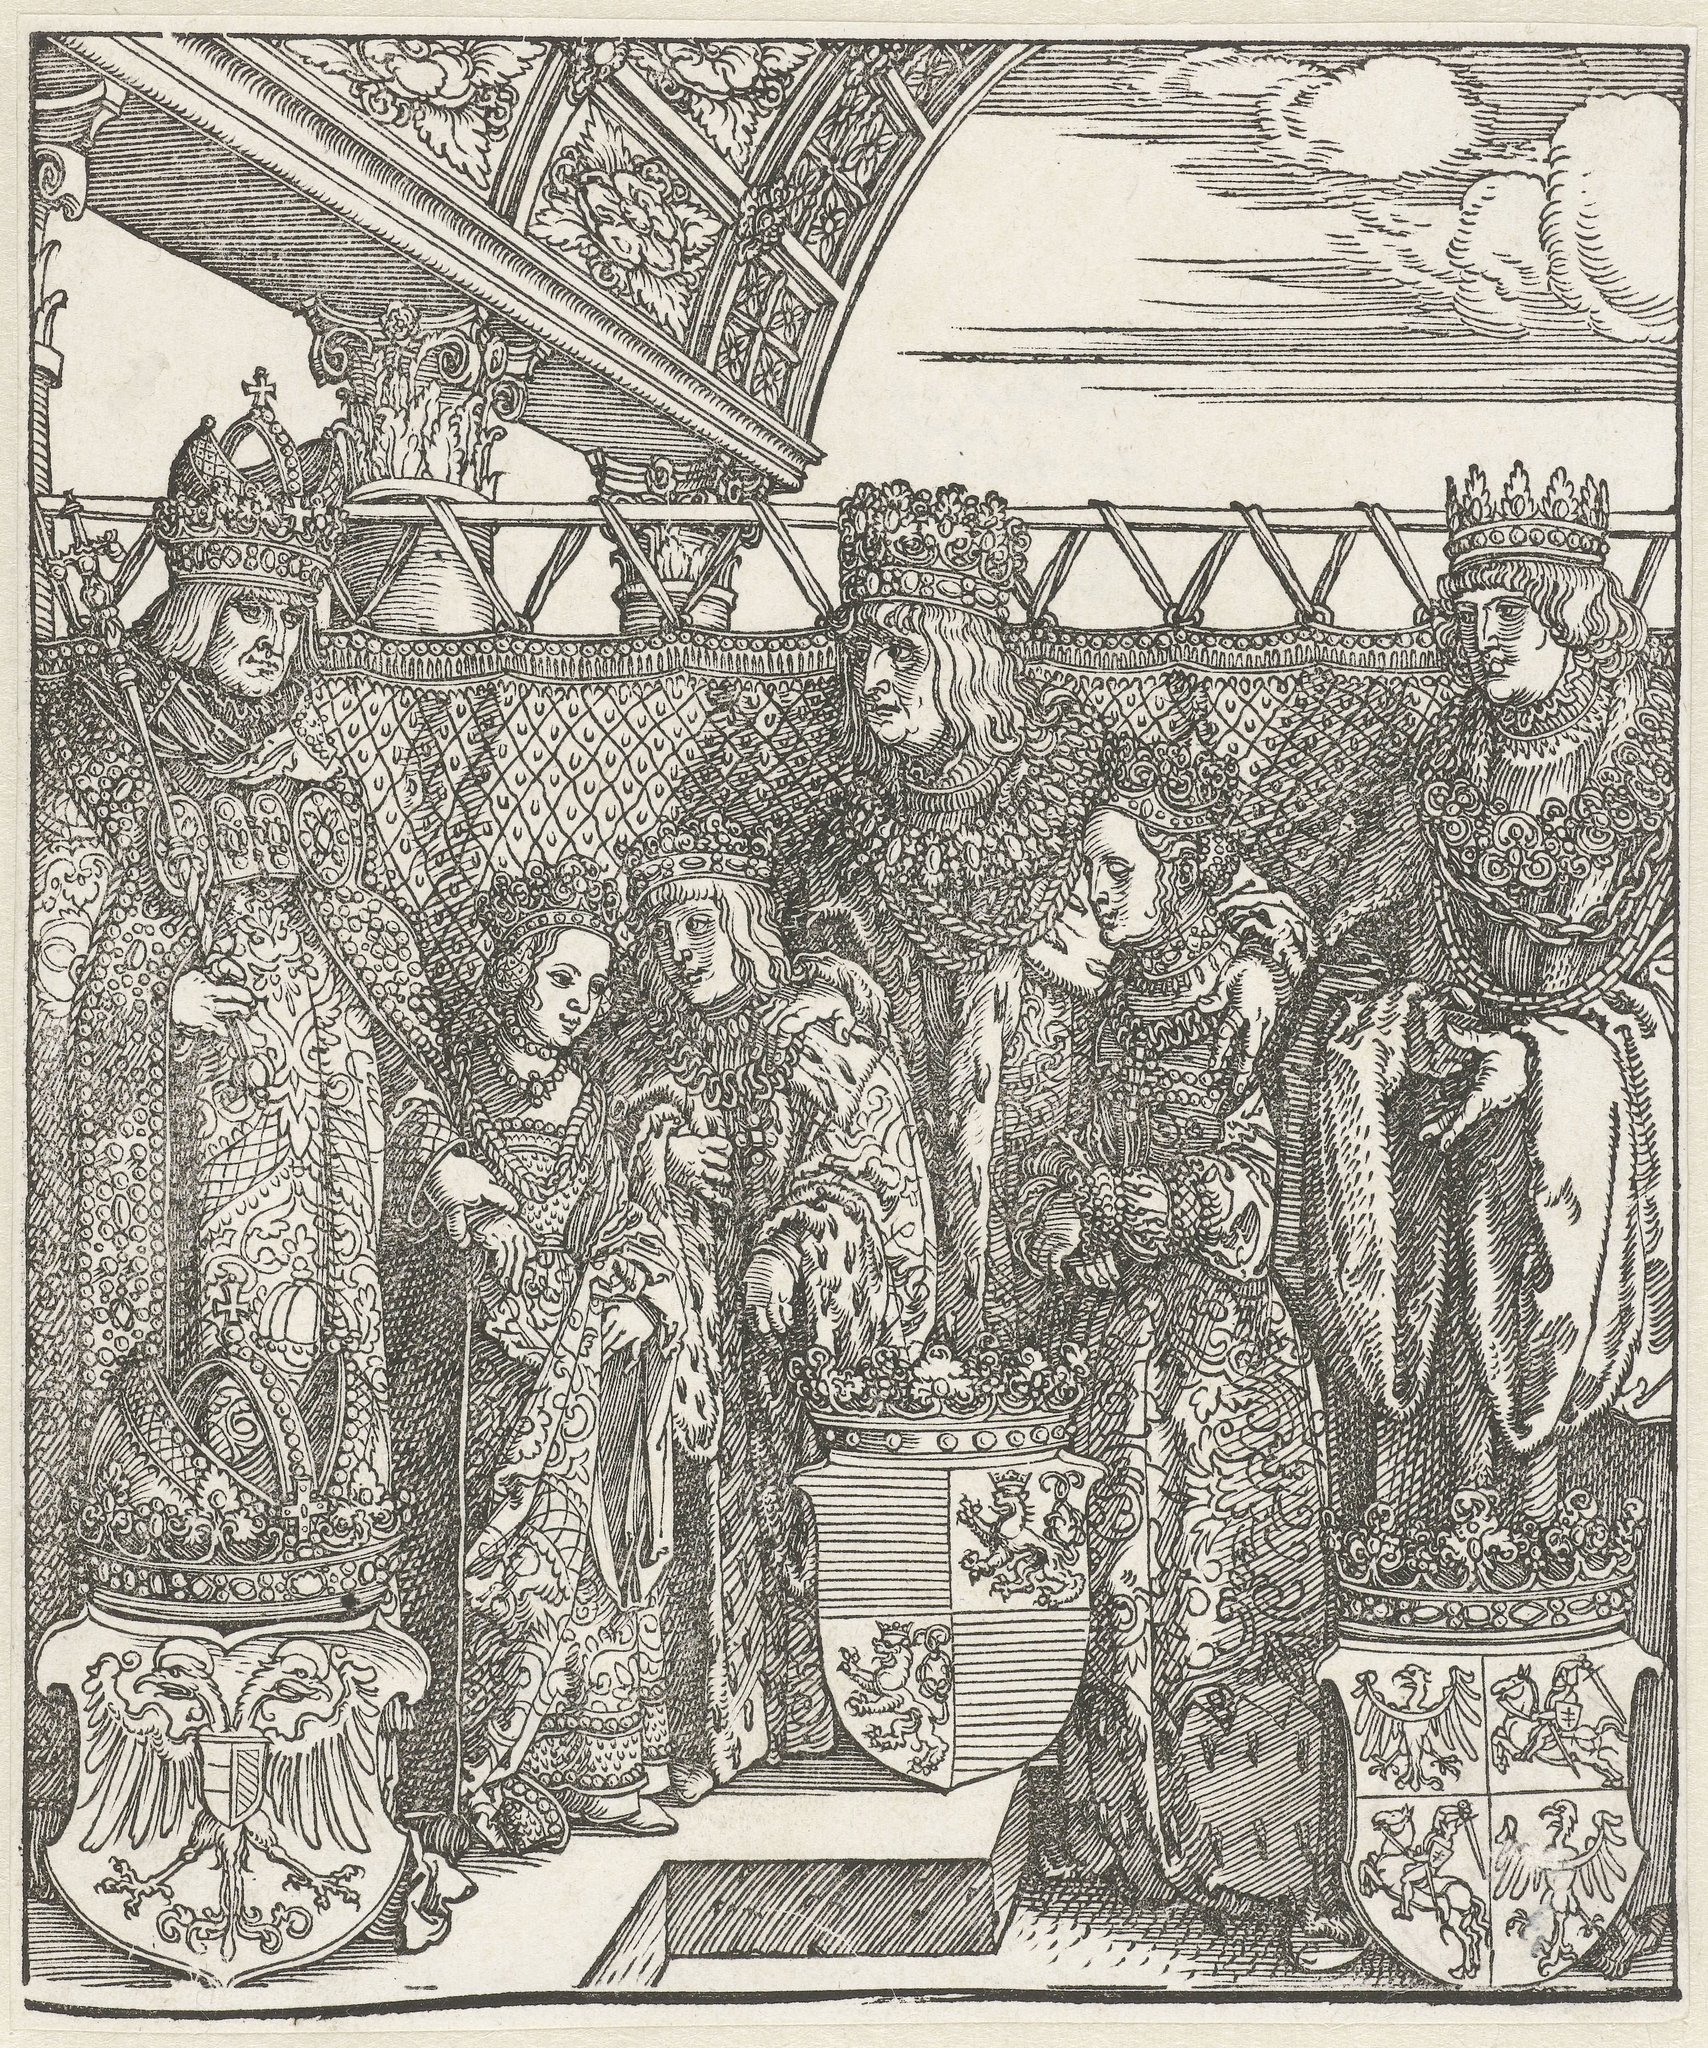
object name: print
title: Triomfboog van keizer Maximiliaan I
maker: albrecht dürer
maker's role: draughtsman, painter, print maker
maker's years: 1471-1528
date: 1515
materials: paper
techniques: woodcut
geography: nuremberg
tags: maximilian i (holy roman emperor), vienna, ferdinand i van habsburg (duits keizer), brussels, maria van hongarije (landvoogdes der nederlanden), prague, parental agreement ~ marriage, king, armorial bearing, heraldry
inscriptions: collector's mark: Lugt 240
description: Voor een gordijn staat Maximiliaan met de koning van Hongarije (Vladislav) en zijn broer (Sigismund). Tussen hen in twee jonge meisjes (Maria en Anna) en één jongetje (Ferdinand of Lodewijk). Bij hun voeten drie wapenschilden. Detail van de triomfboog van keizer Maximiliaan I.